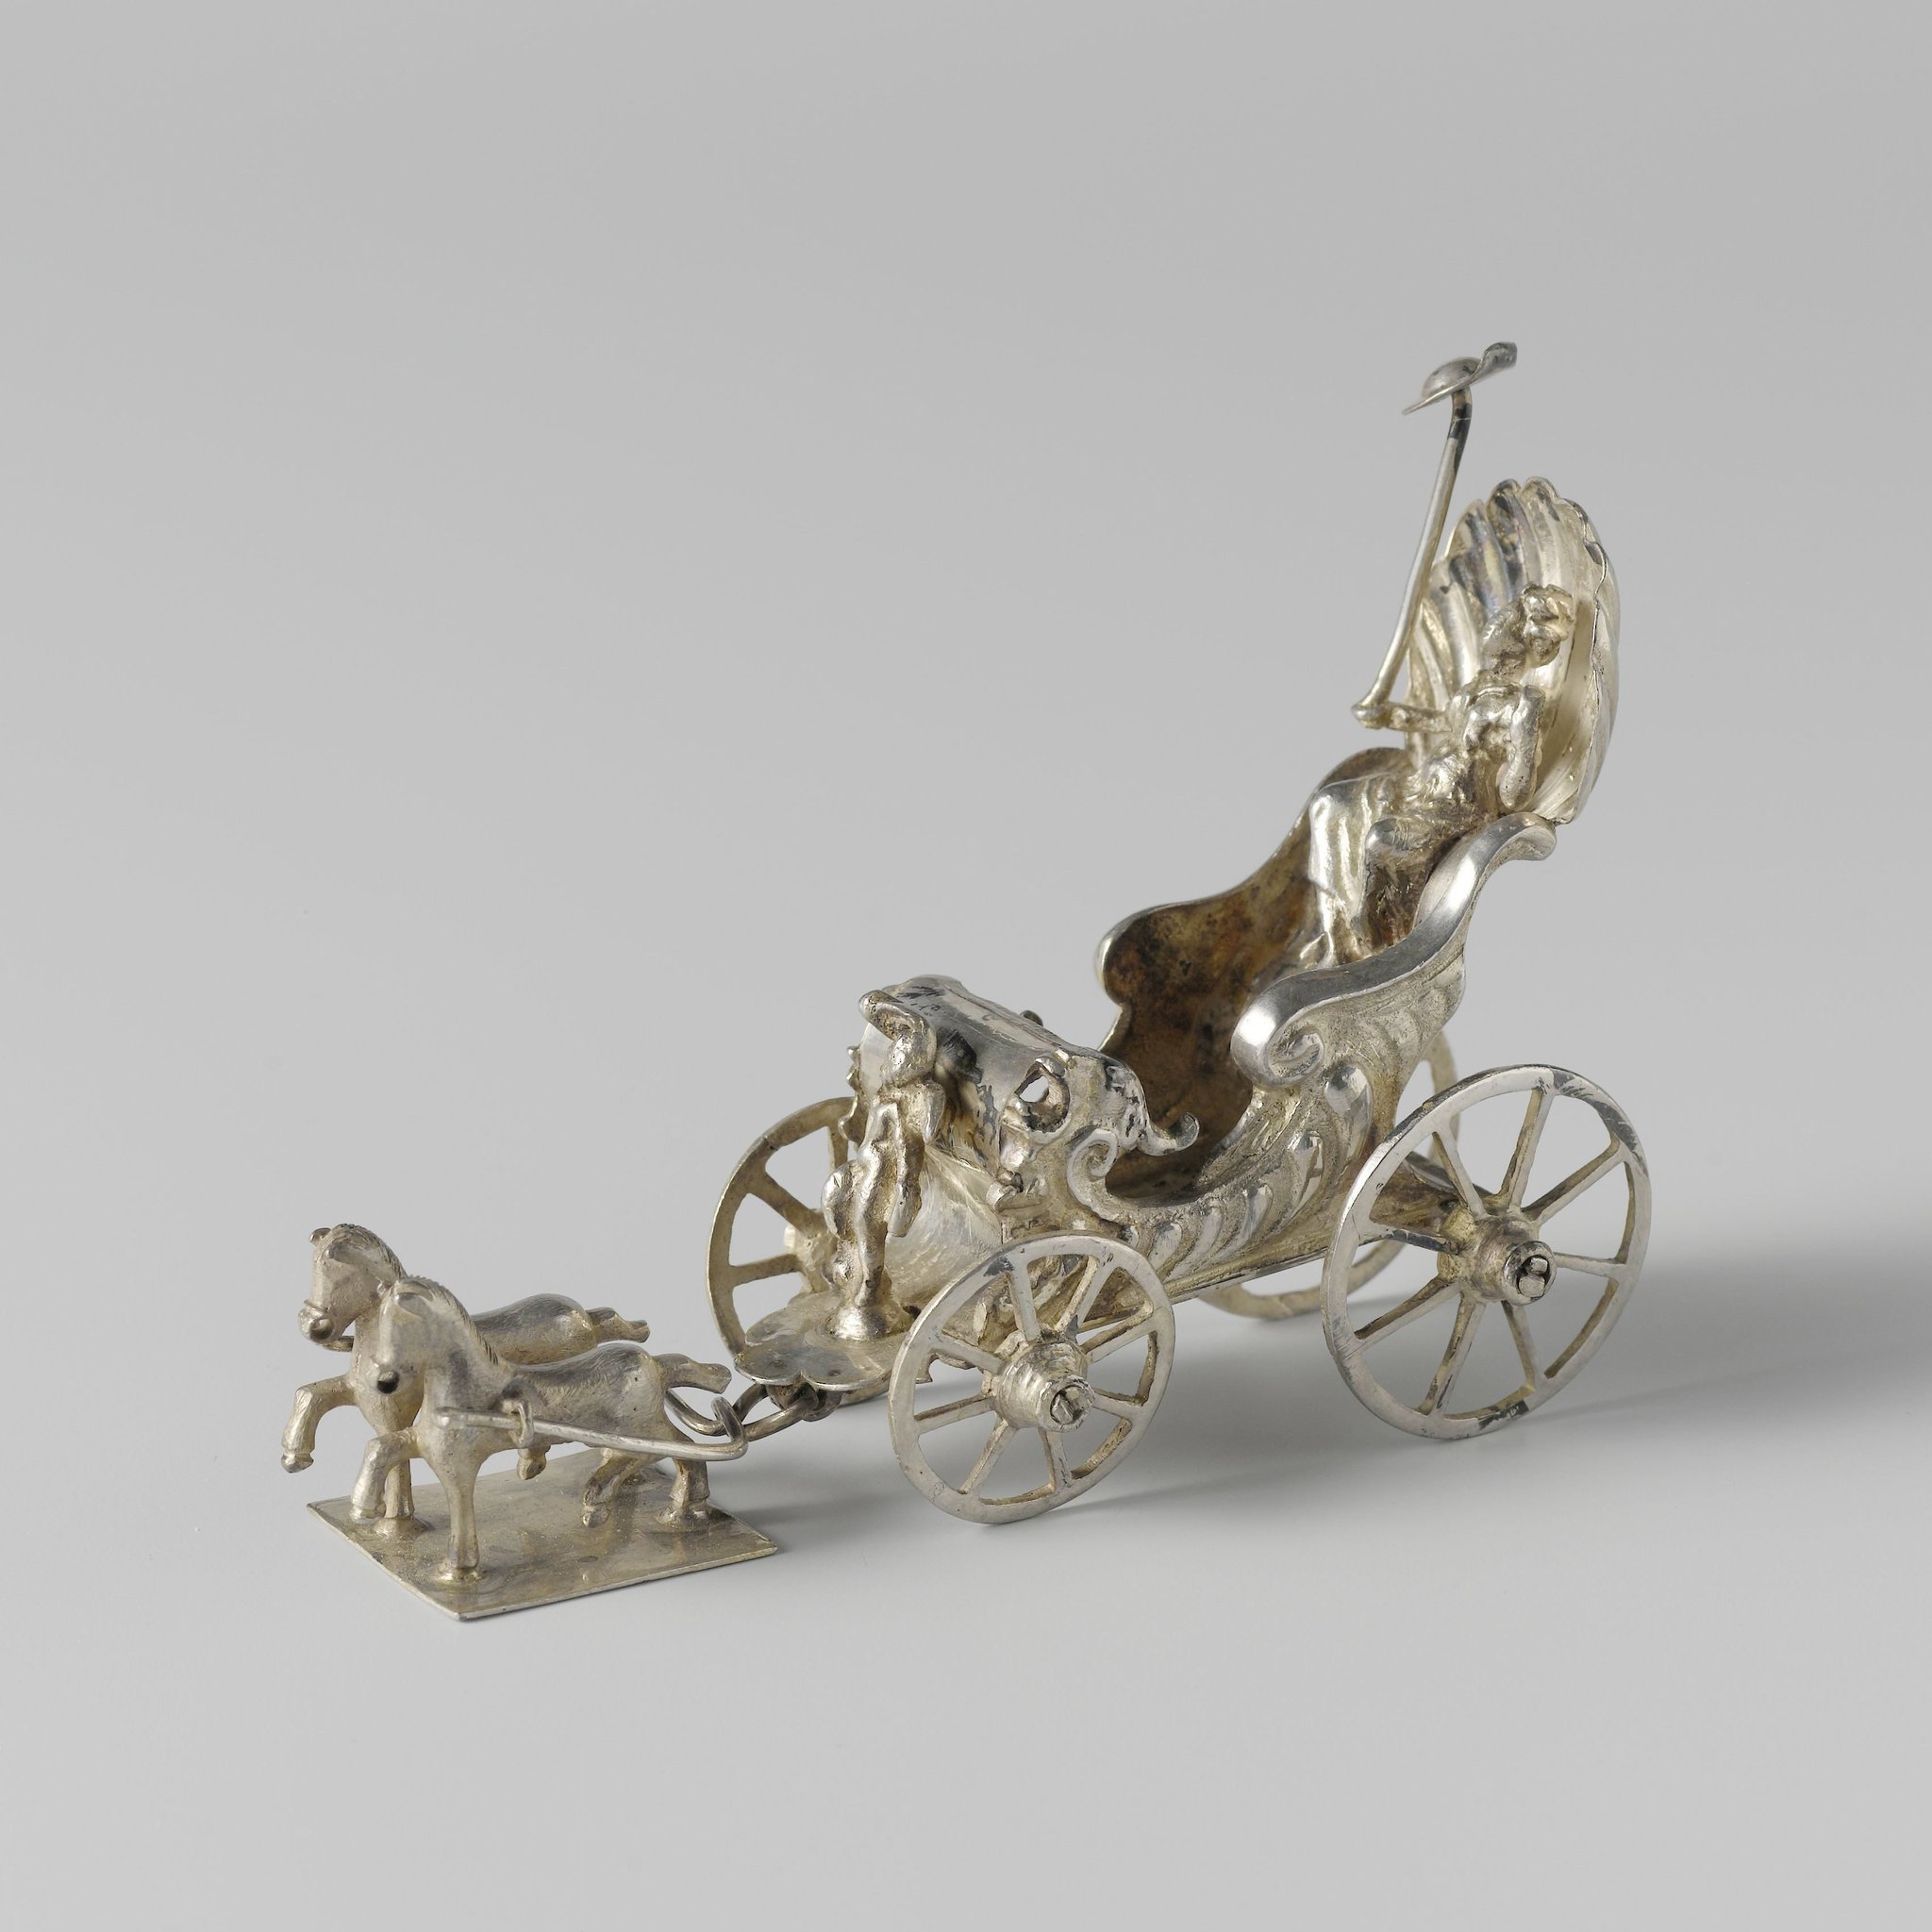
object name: miniature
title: Triumphal Chariot of Liberty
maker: michiel maenbeeck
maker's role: silversmith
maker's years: 1634-1682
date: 1666-1682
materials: silver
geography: amsterdam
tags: chariot, triumphal car, freedom, liberty; 'libertà' (ripa)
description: During the 17th century, decorated chariots representing abstract themes made their way through the streets on special occasions. This one represents Liberty, with her hat and lance. In ancient Rome such attributes emphasized the new status of previously enslaved people. As full citizens, they were permitted to wear a hat on their shaved head and to defend themselves with weapons.